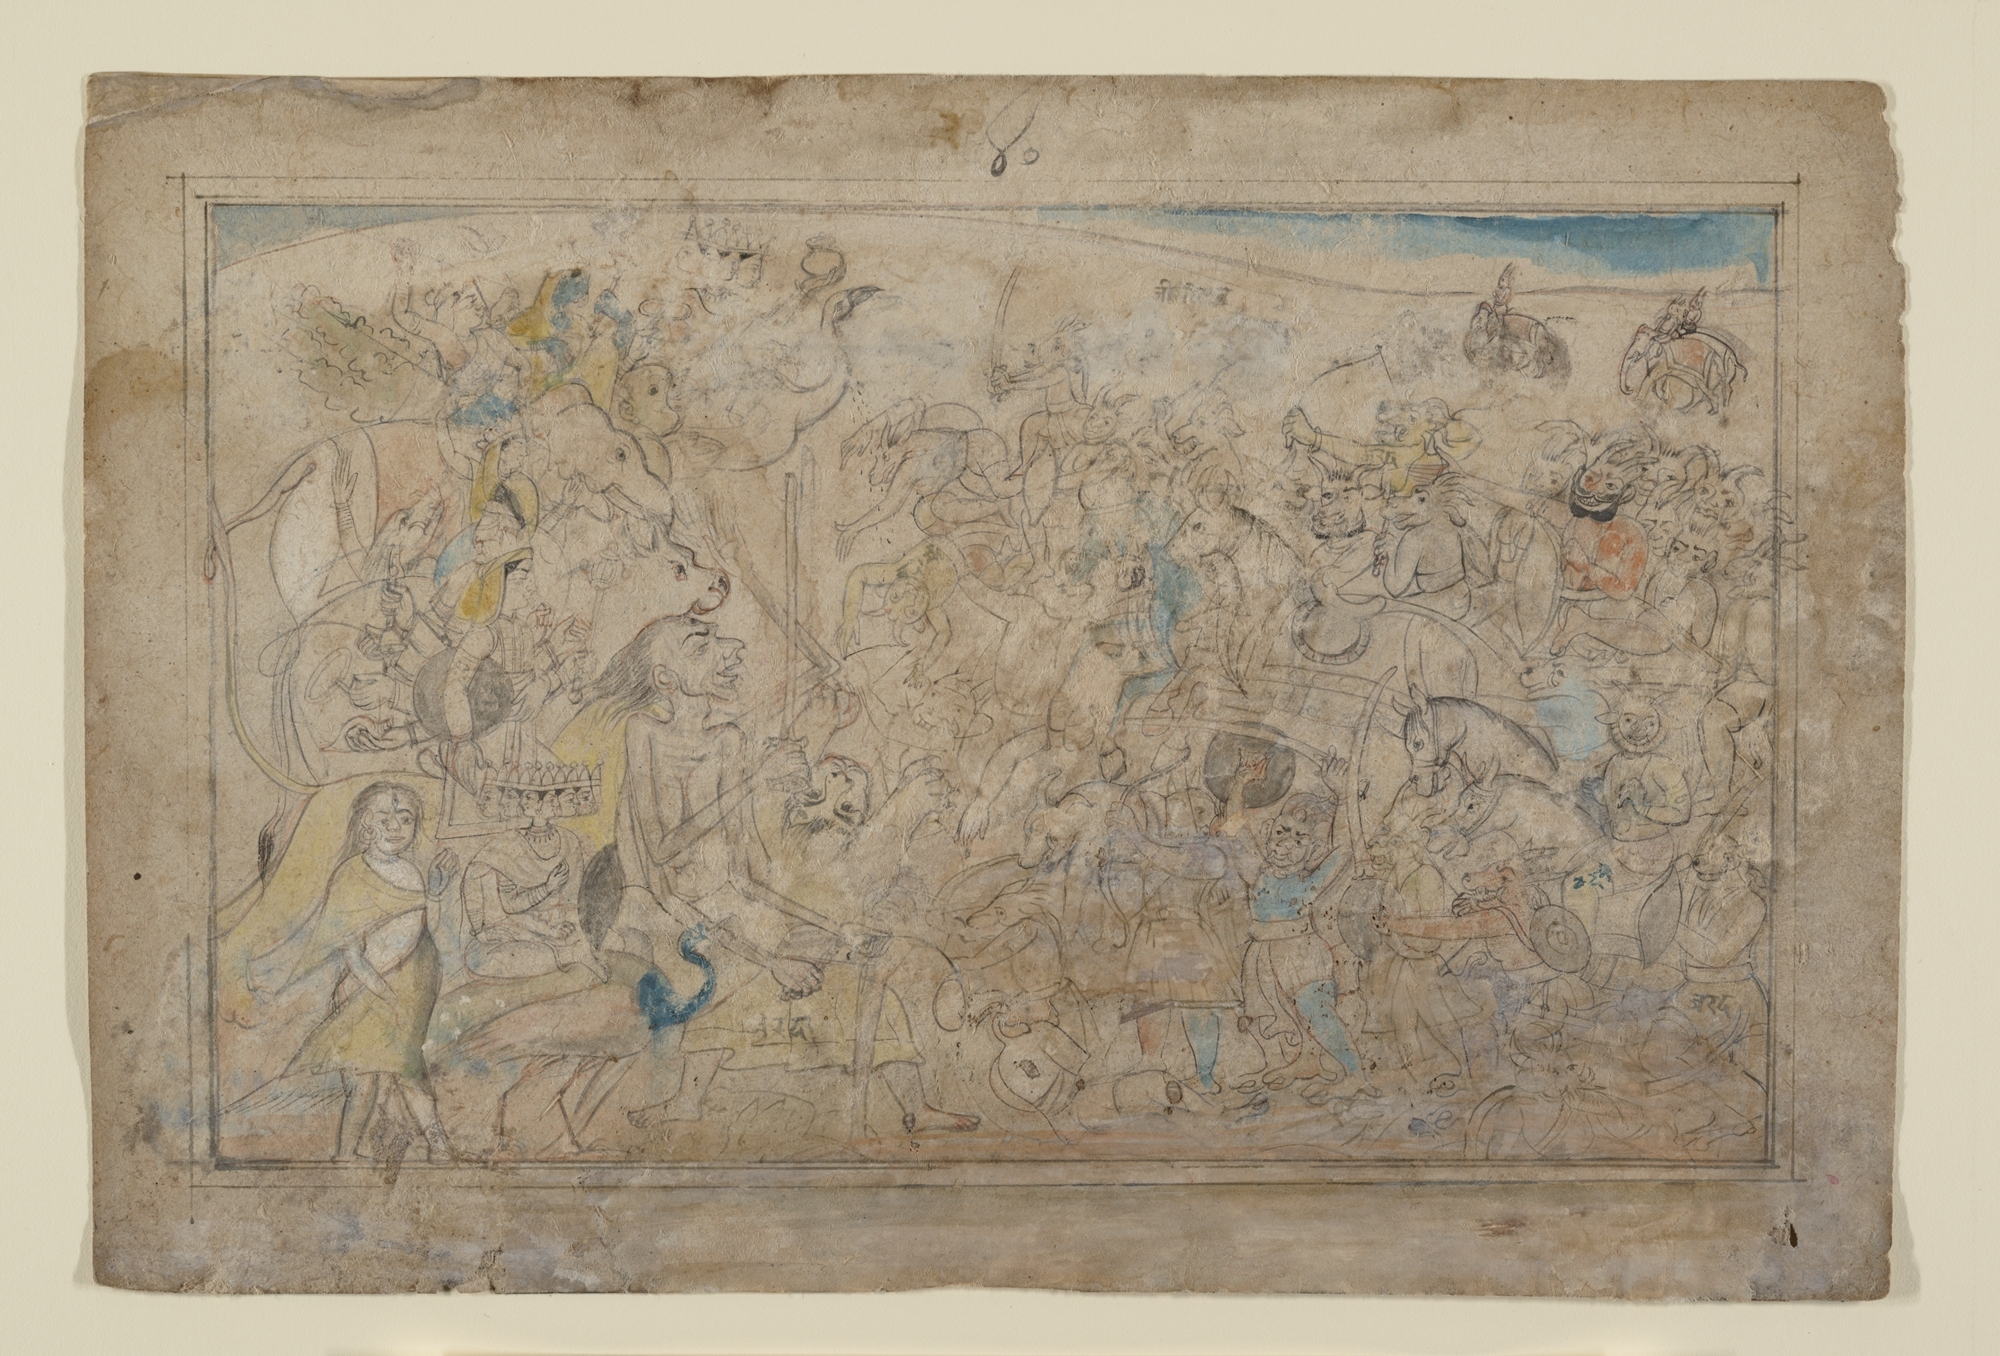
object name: painting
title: Durga, Kali, and Five Matrikas Battle the Daitya Army of the Demon Shumbha: Scene from the Devi Mahatmya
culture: indian, guler, himachal pradesh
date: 1780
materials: ink, paper, watercolor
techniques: wash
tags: birds,battles,elephants,horses,demons,goddess,durga